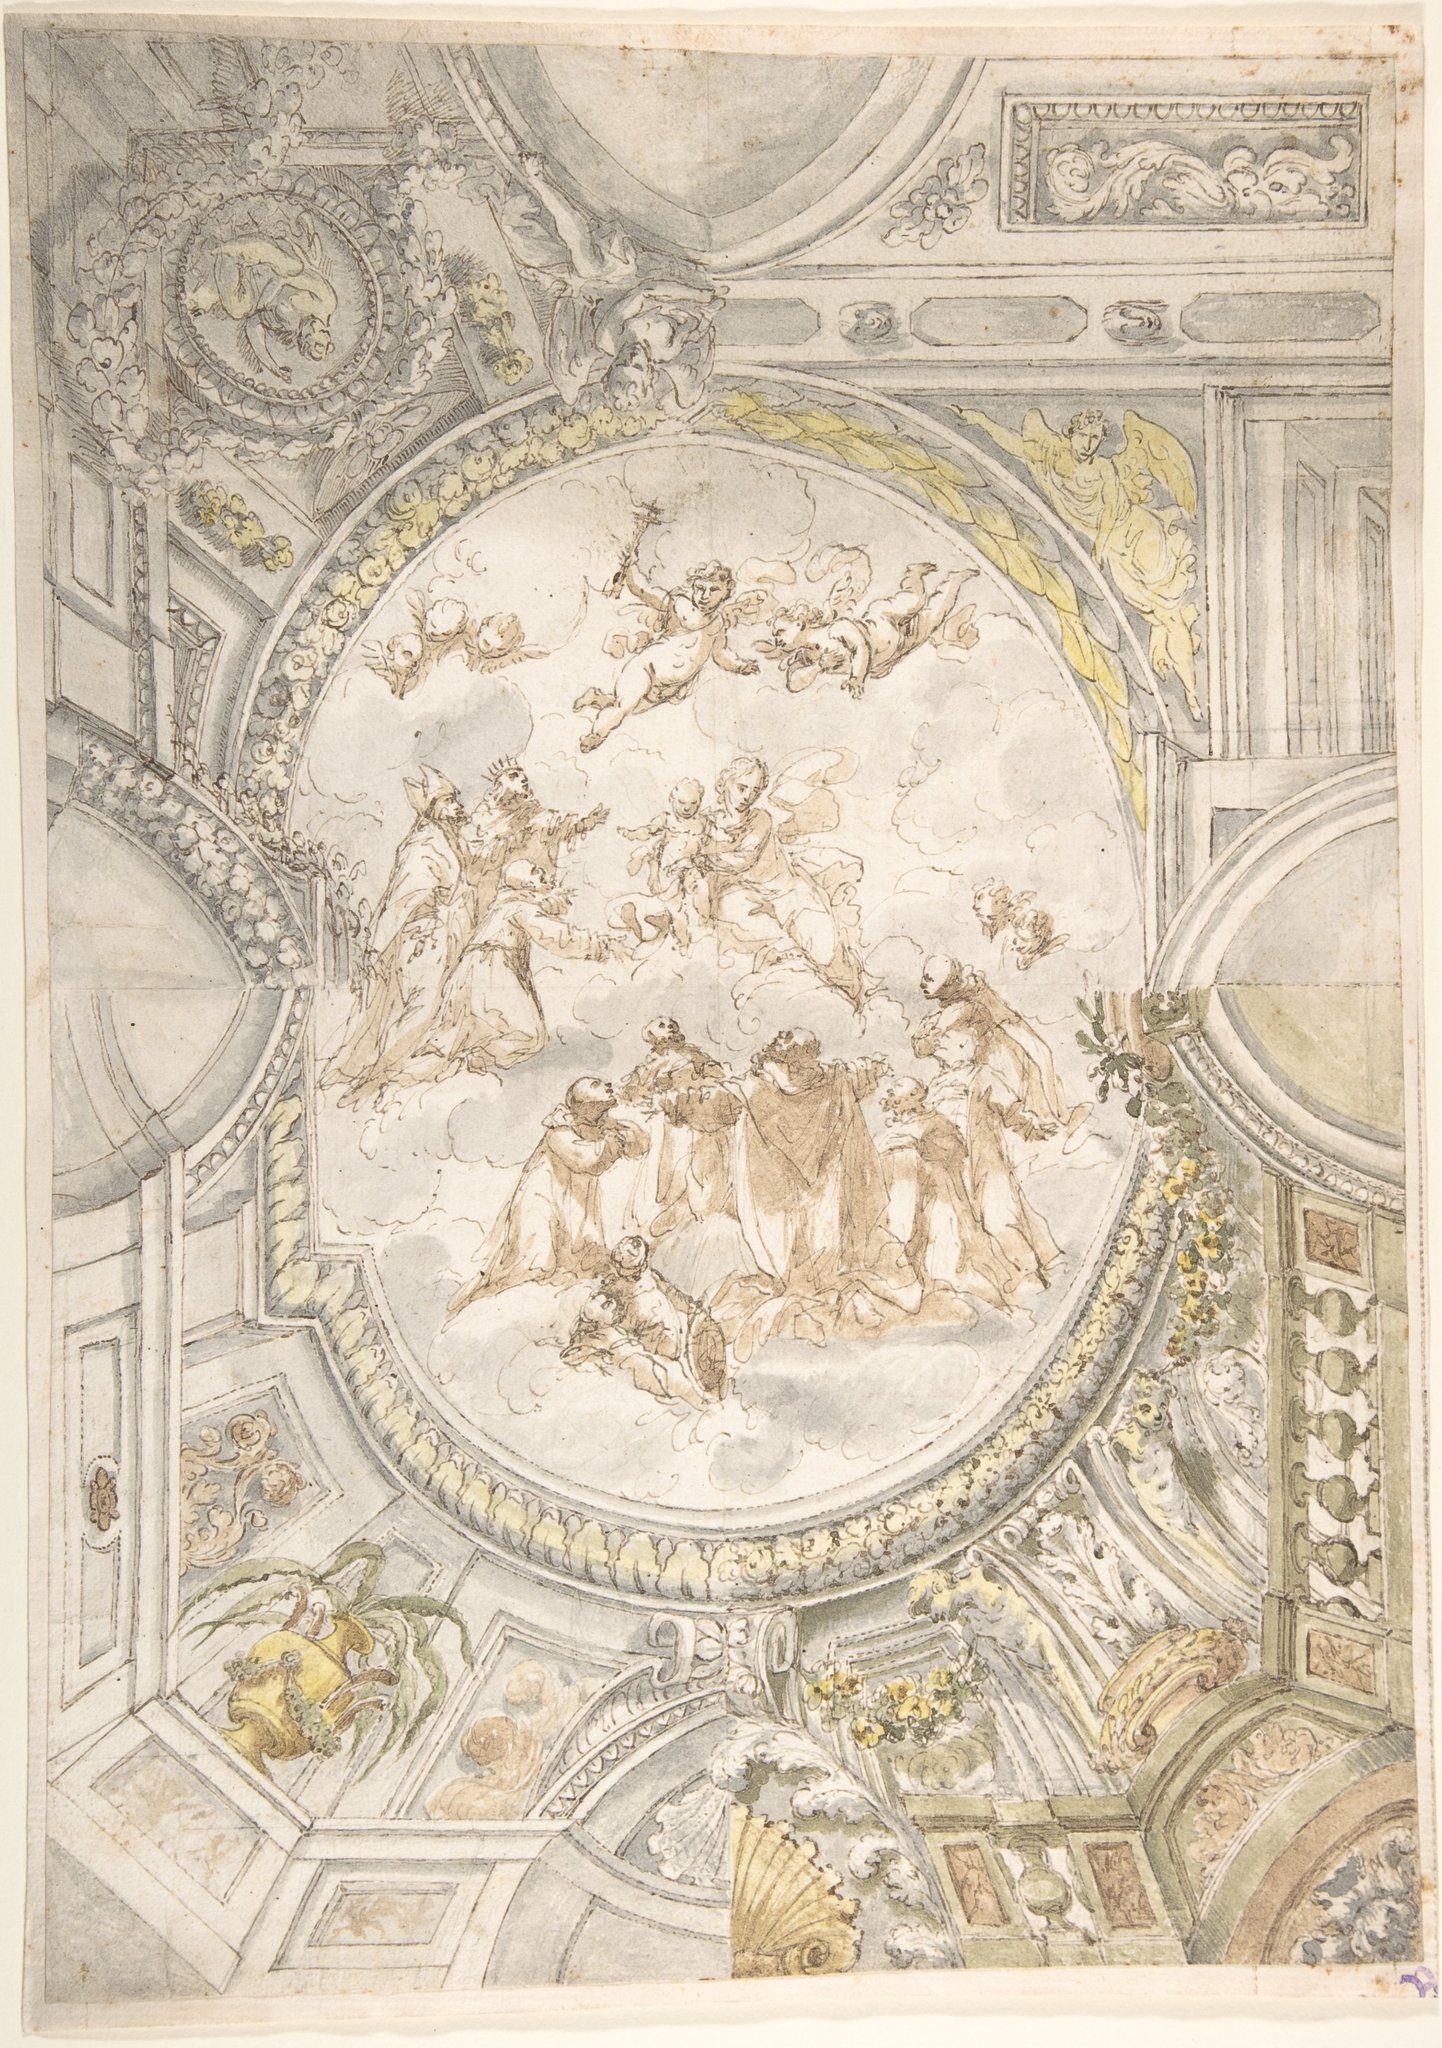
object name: drawing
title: Design for a Ceiling with Virgin and Child in Glory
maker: anonymous, italian, 18th century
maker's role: artist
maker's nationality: italian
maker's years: 1700-1800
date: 1701-1800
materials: ink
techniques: pen, wash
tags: angels,madonna and child